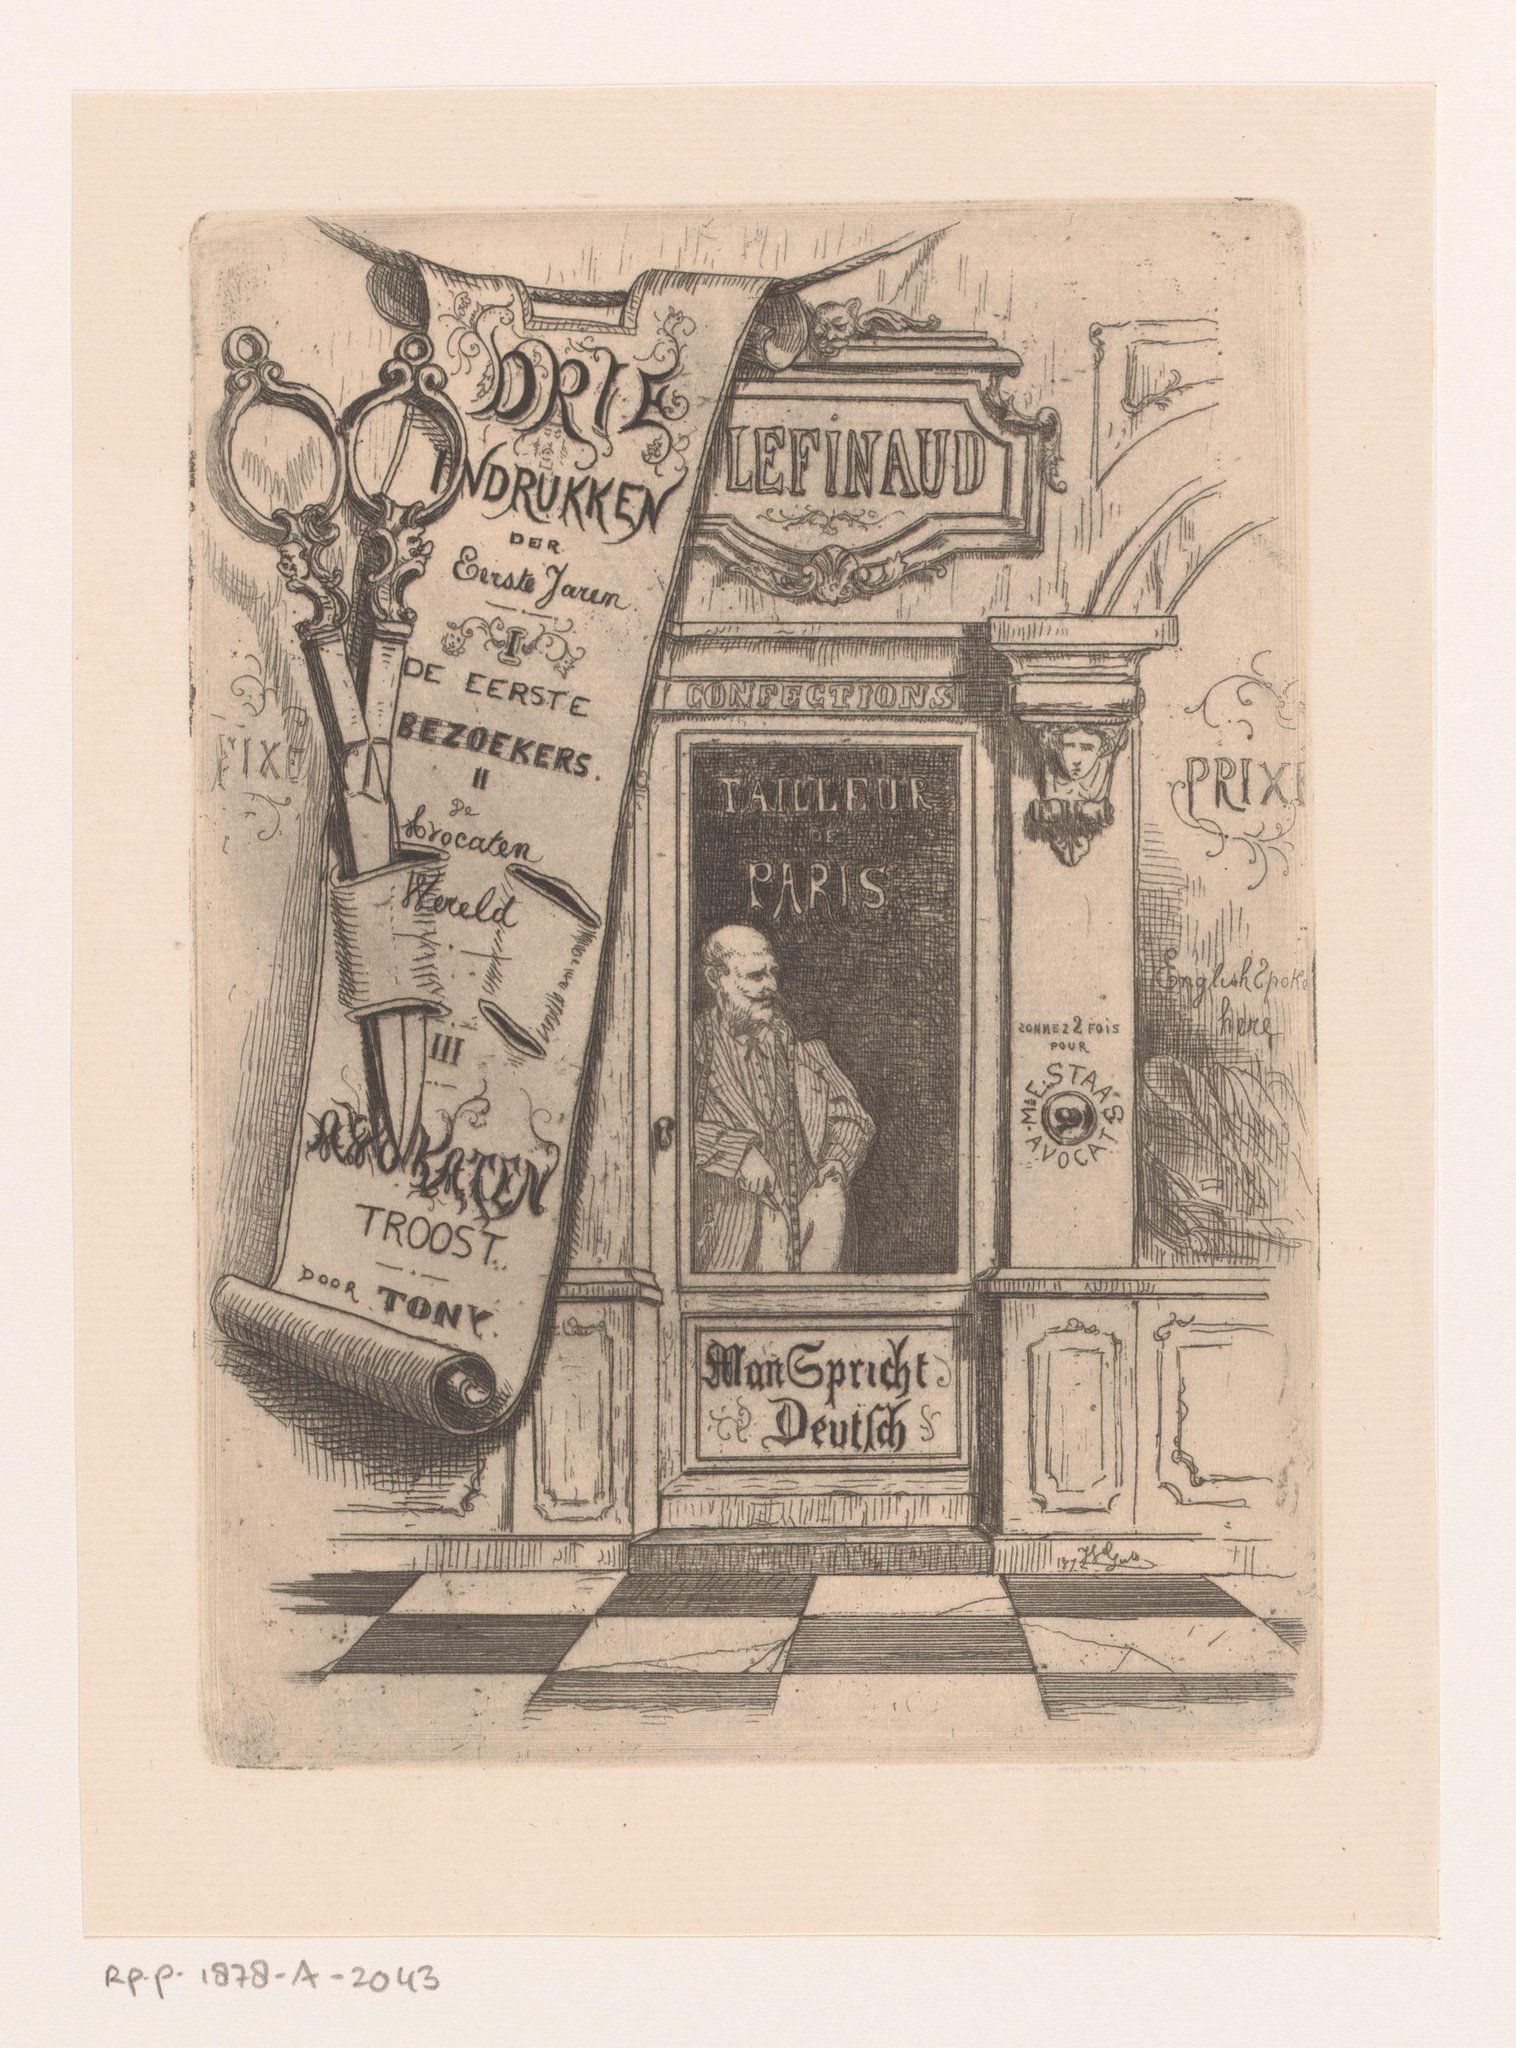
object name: book illustration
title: Man achter de deur van een kleermakerswinkel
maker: willem geets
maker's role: print maker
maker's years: 1838-1919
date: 1872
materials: paper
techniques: etching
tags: shop, store, tailor, dressmaker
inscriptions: collector's mark: Lugt 2228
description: Prent uit: Bergmann, Anton. Ernest Staas, advocaat: schetsen en beelden. Gent: Hoste, Den Haag: Martinus Nijhoff, [1874-1875]. De prent is de titelpagina van hoofdstuk vier.